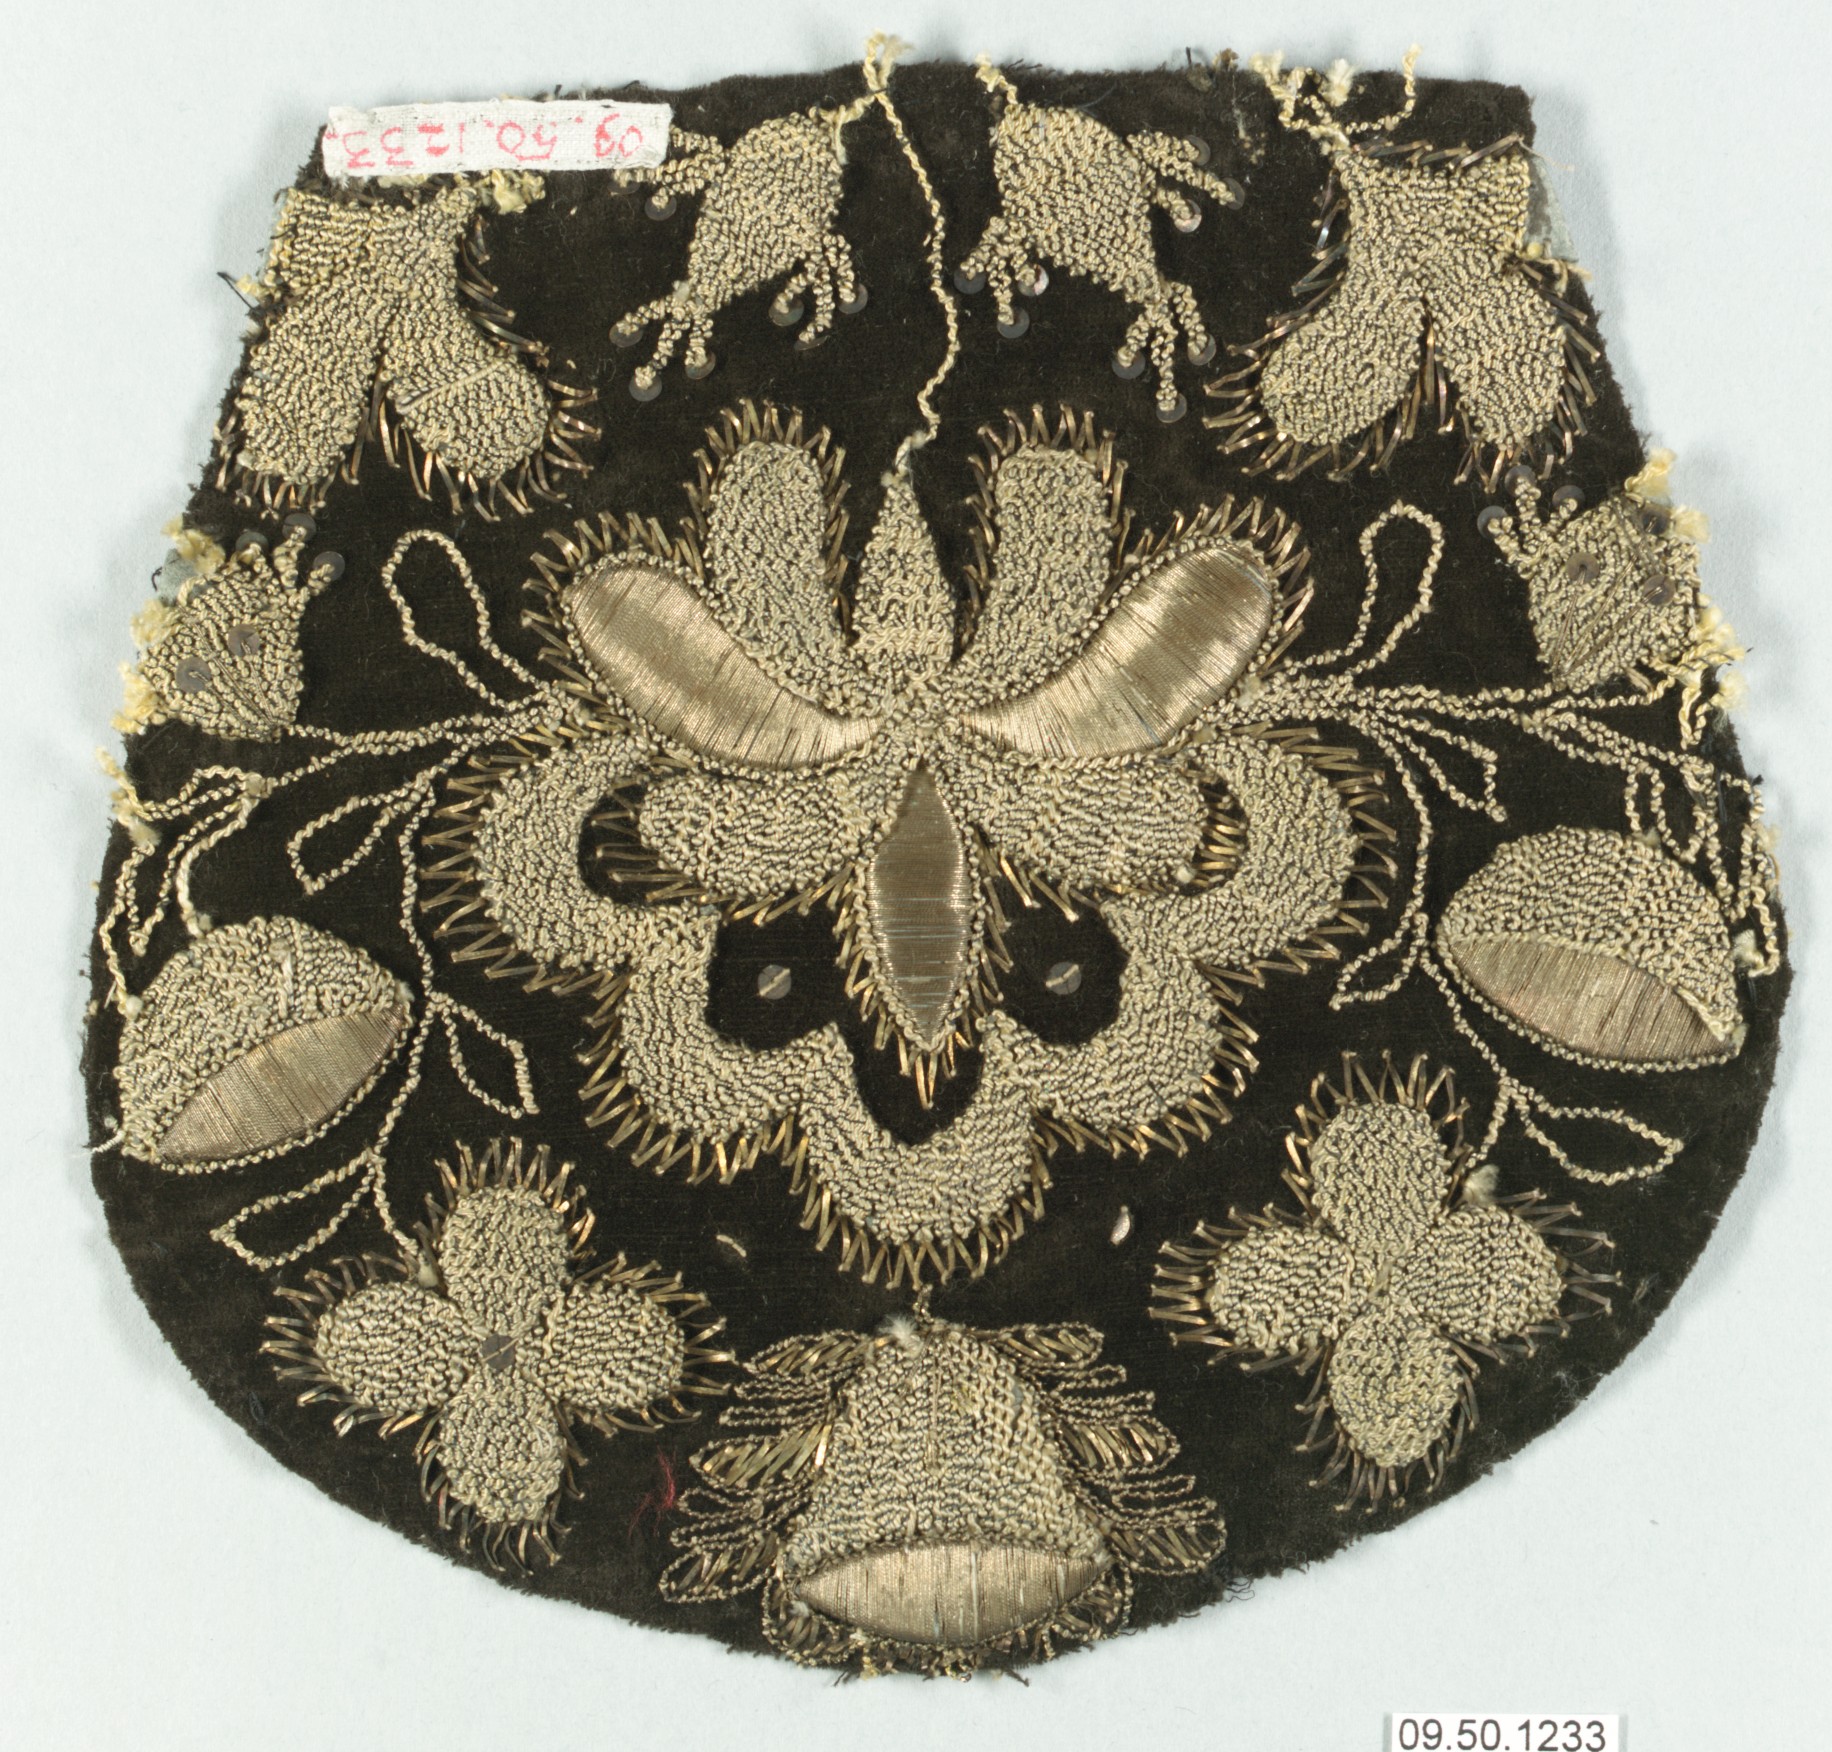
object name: cap crown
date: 1801-1833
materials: metal thread, velvet